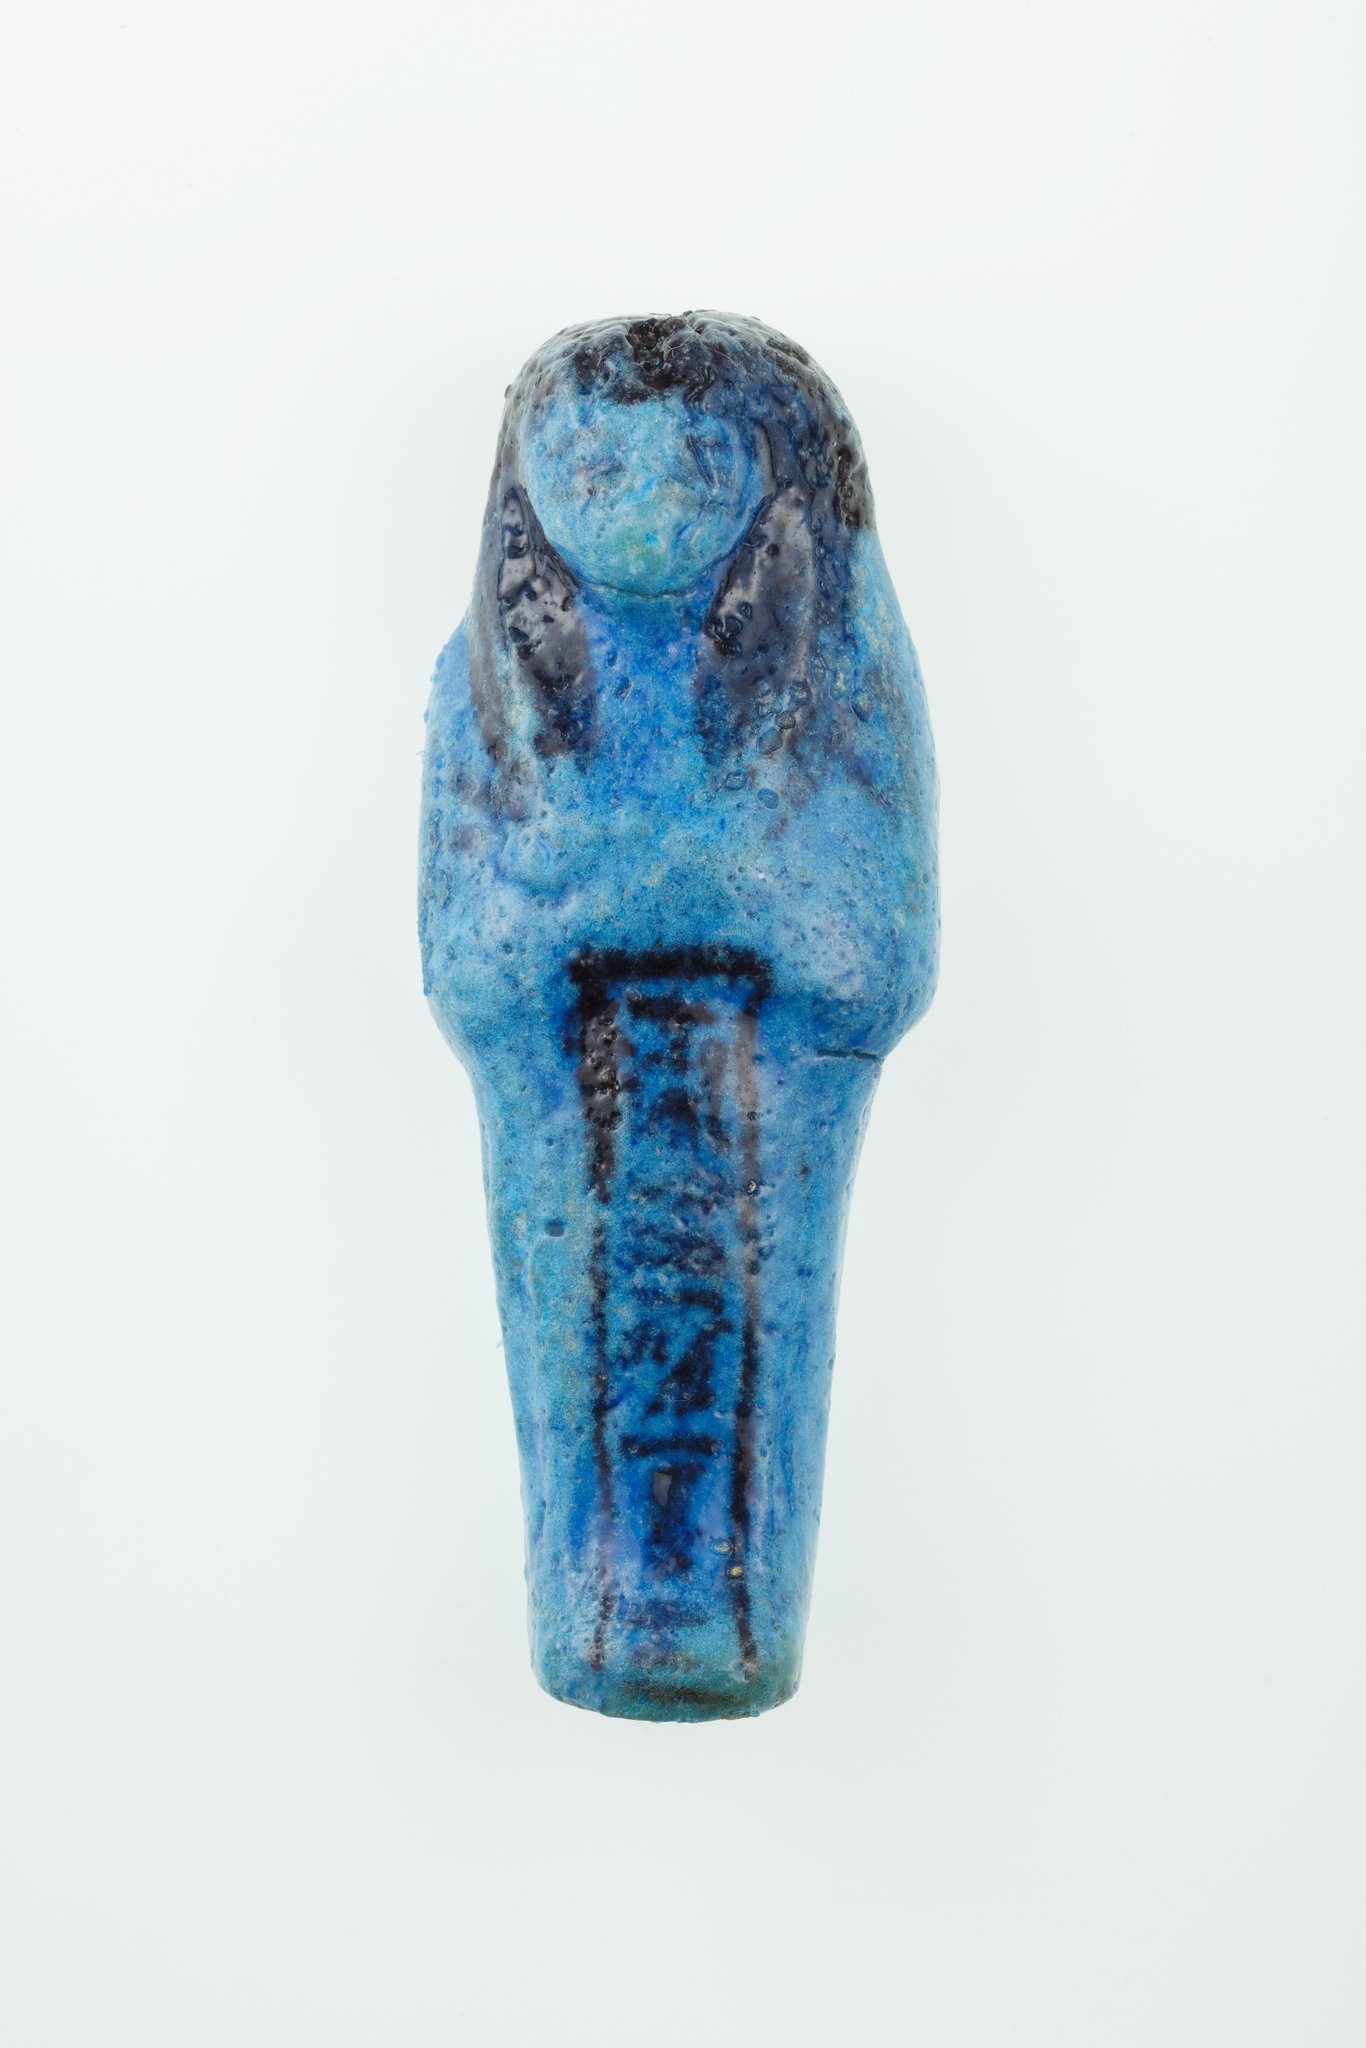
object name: shabti, worker, nauny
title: Worker Shabti of Nauny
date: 1050 BCE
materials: faience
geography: egypt